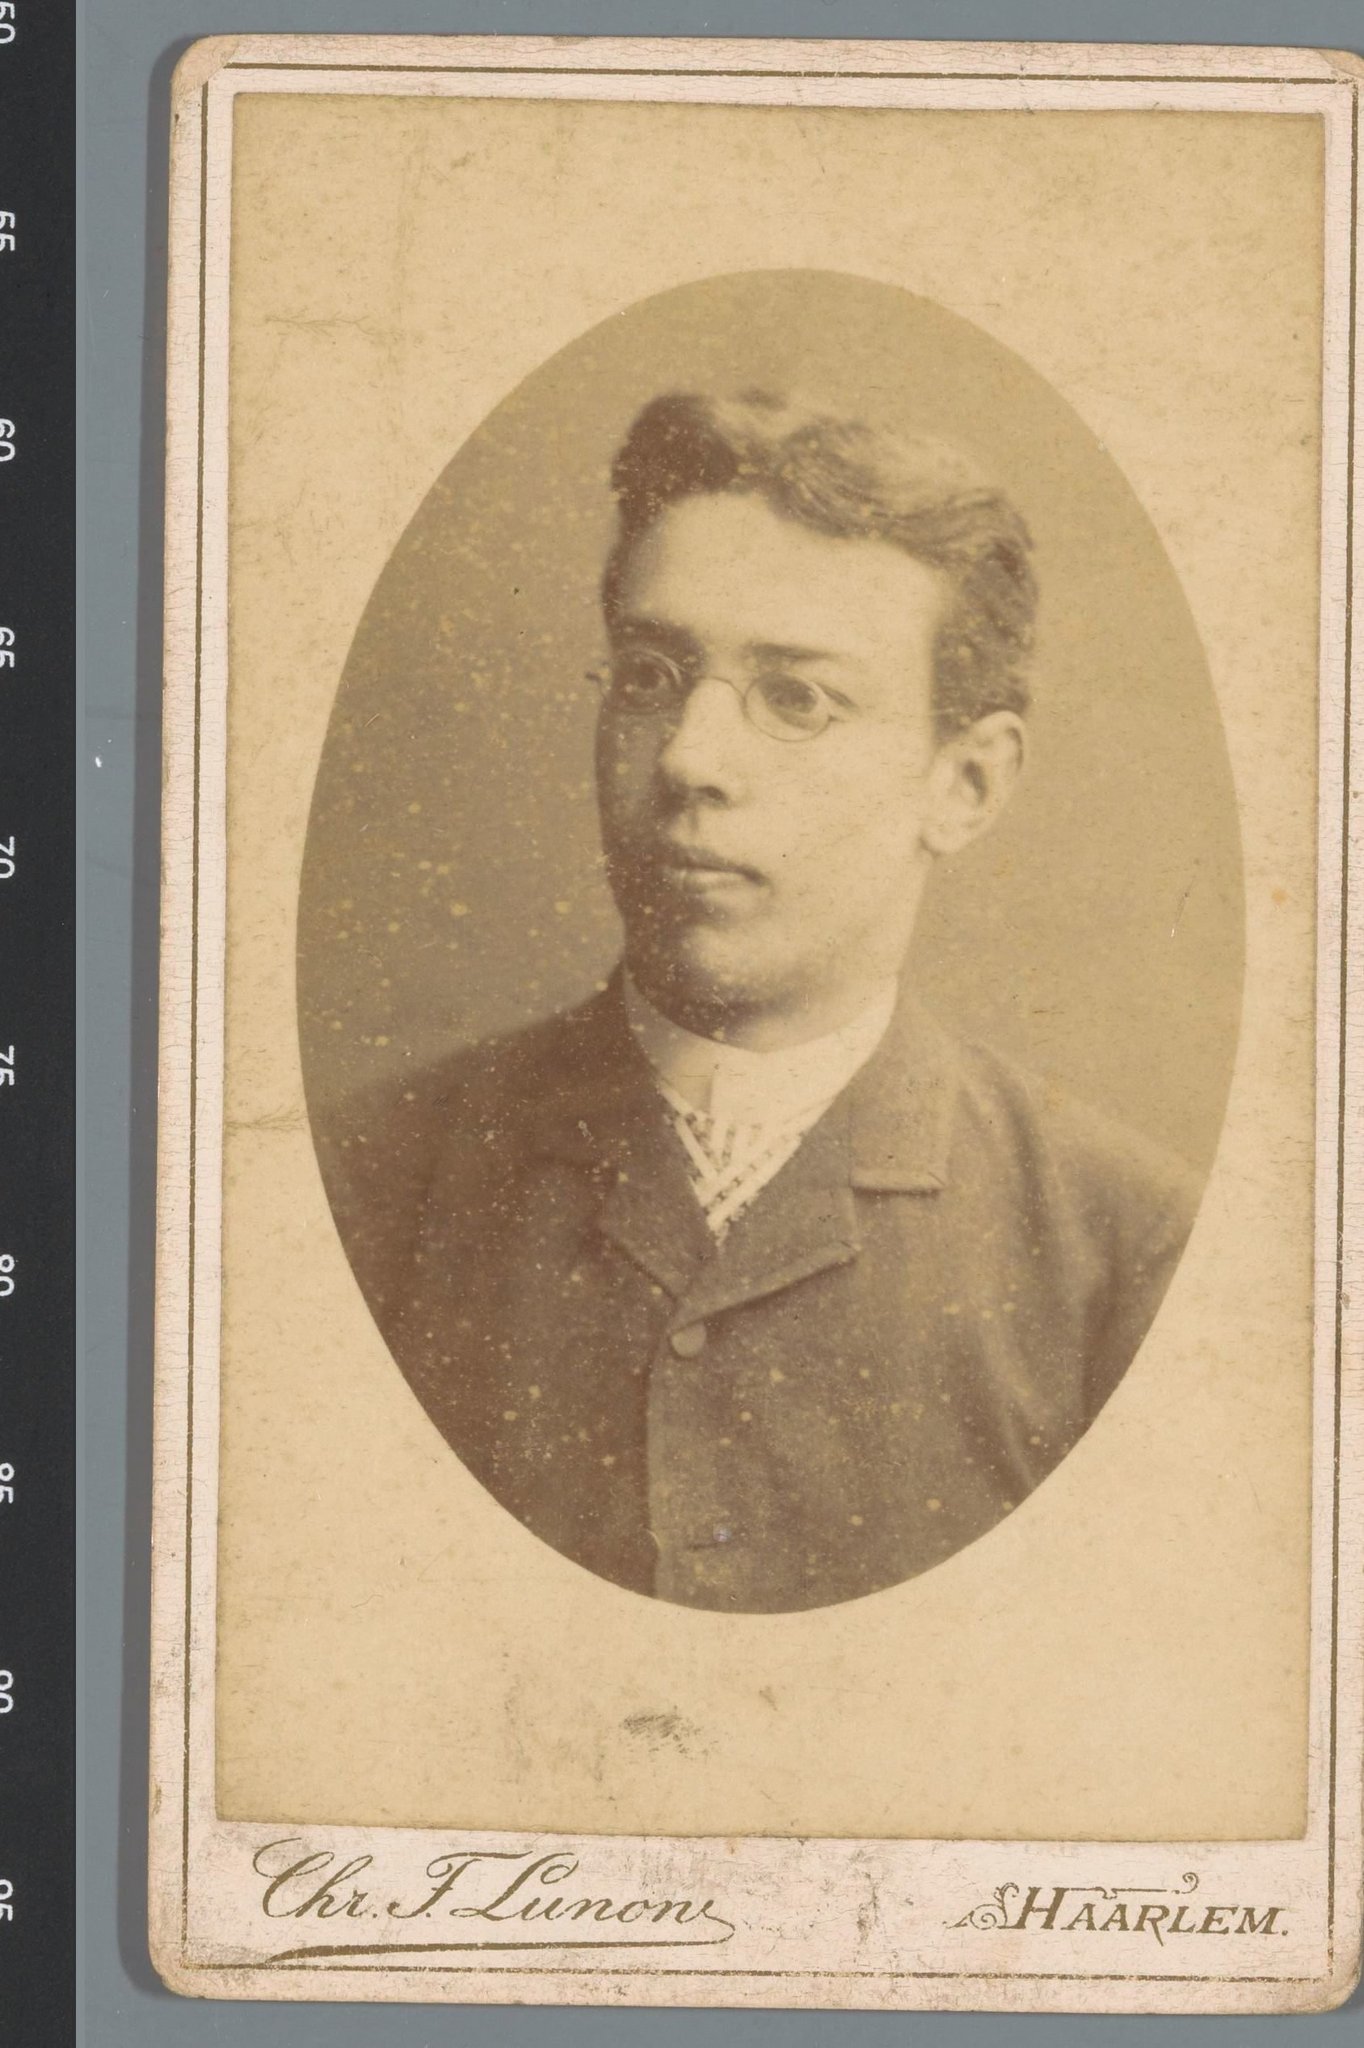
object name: photograph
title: Portret van een onbekende man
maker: fredrich christiaan lünow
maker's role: fotograaf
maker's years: 1857-1925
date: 1888-1899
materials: cardboard, paper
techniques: albumen print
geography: haarlem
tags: adult man, historical persons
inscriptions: inscription: ‘Chr. F. Lunon/ Photograaf/ Barteljoresstraat 17,/ HAARLEM./ De platen blijven ter nabesetlling bewaard./ Speciale inrichting voor vergrootingen.’